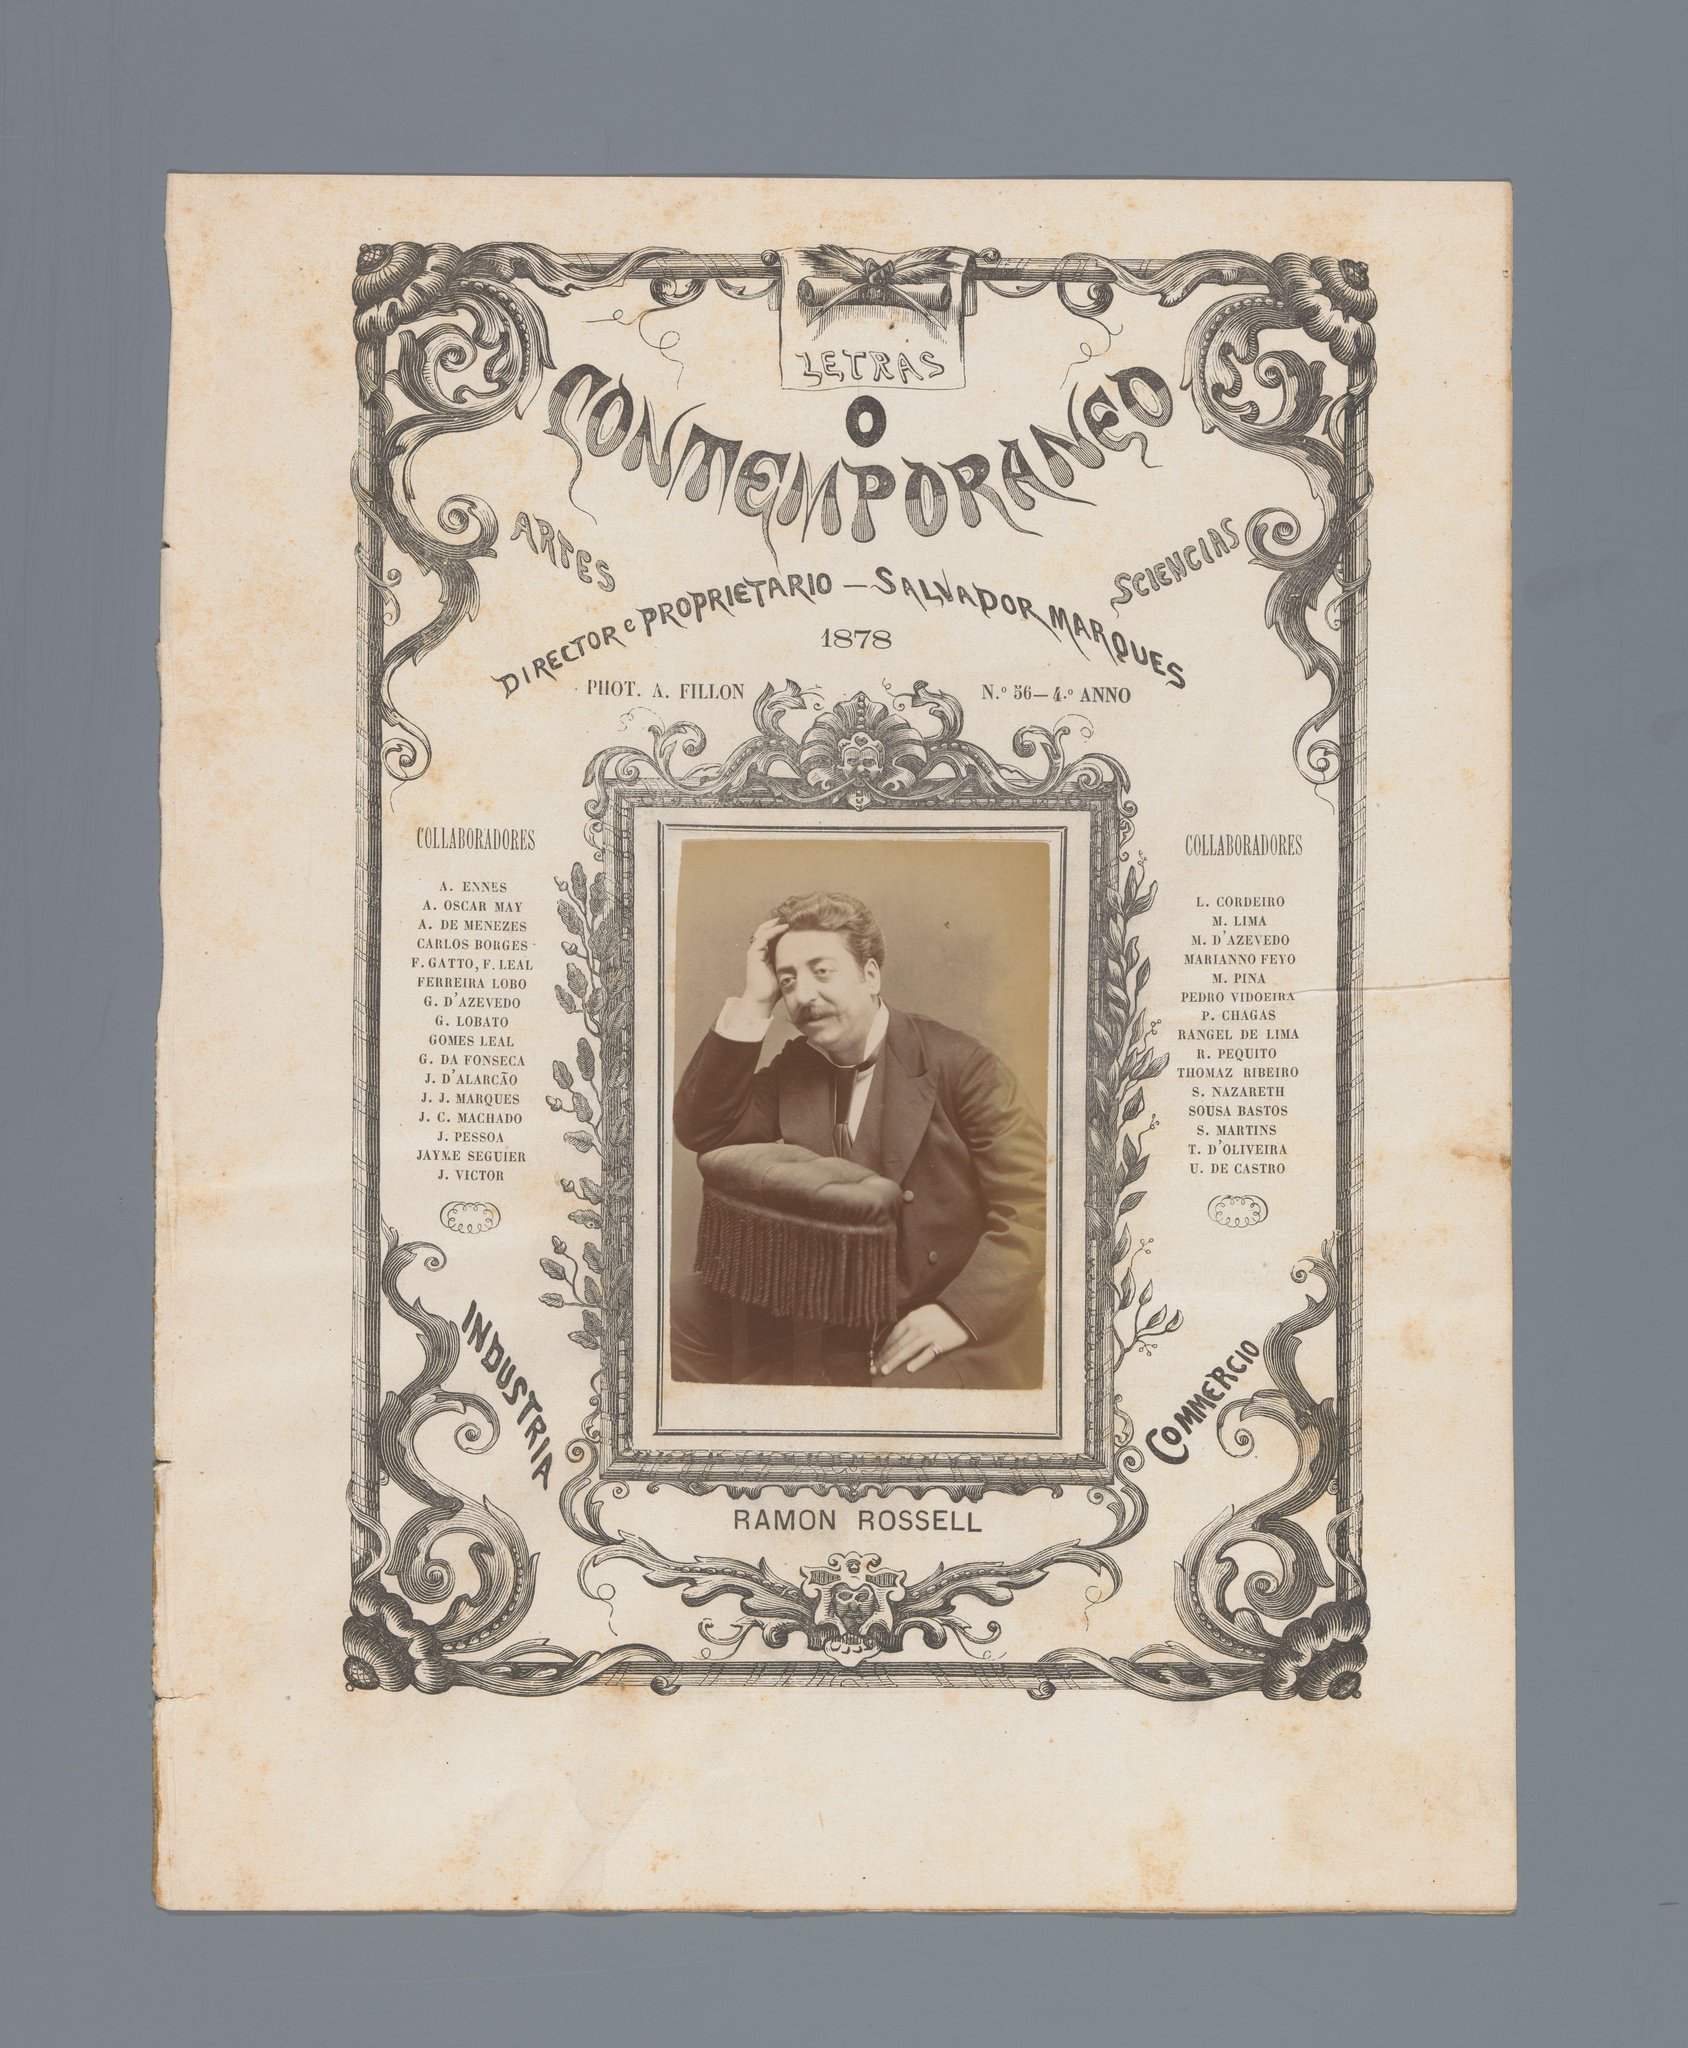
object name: magazine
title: O contemporaneo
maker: alfred fillon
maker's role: fotograaf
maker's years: 1825-1881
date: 1873-1878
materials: paper, photographic support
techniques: albumen print, printing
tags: historical persons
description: Op de voorpagina bevindt zich een portret van Ramón Rosell.